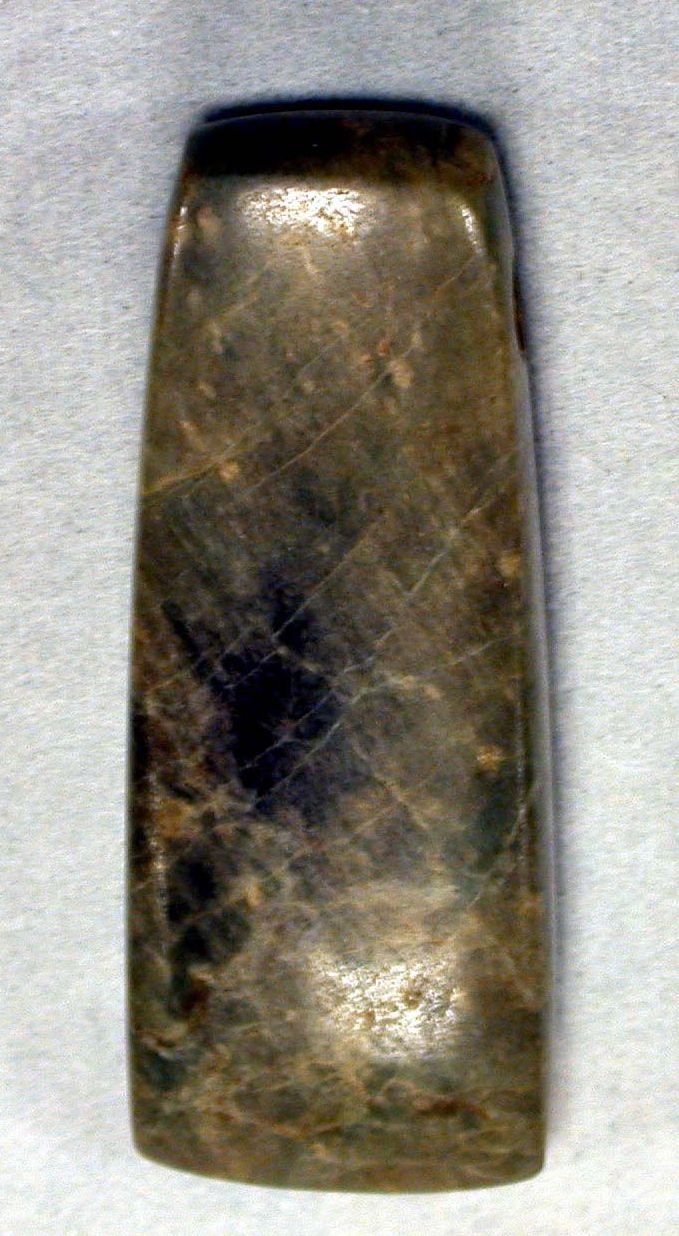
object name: pendant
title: Celt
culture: mexican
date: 1501-1600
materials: stone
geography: mexico